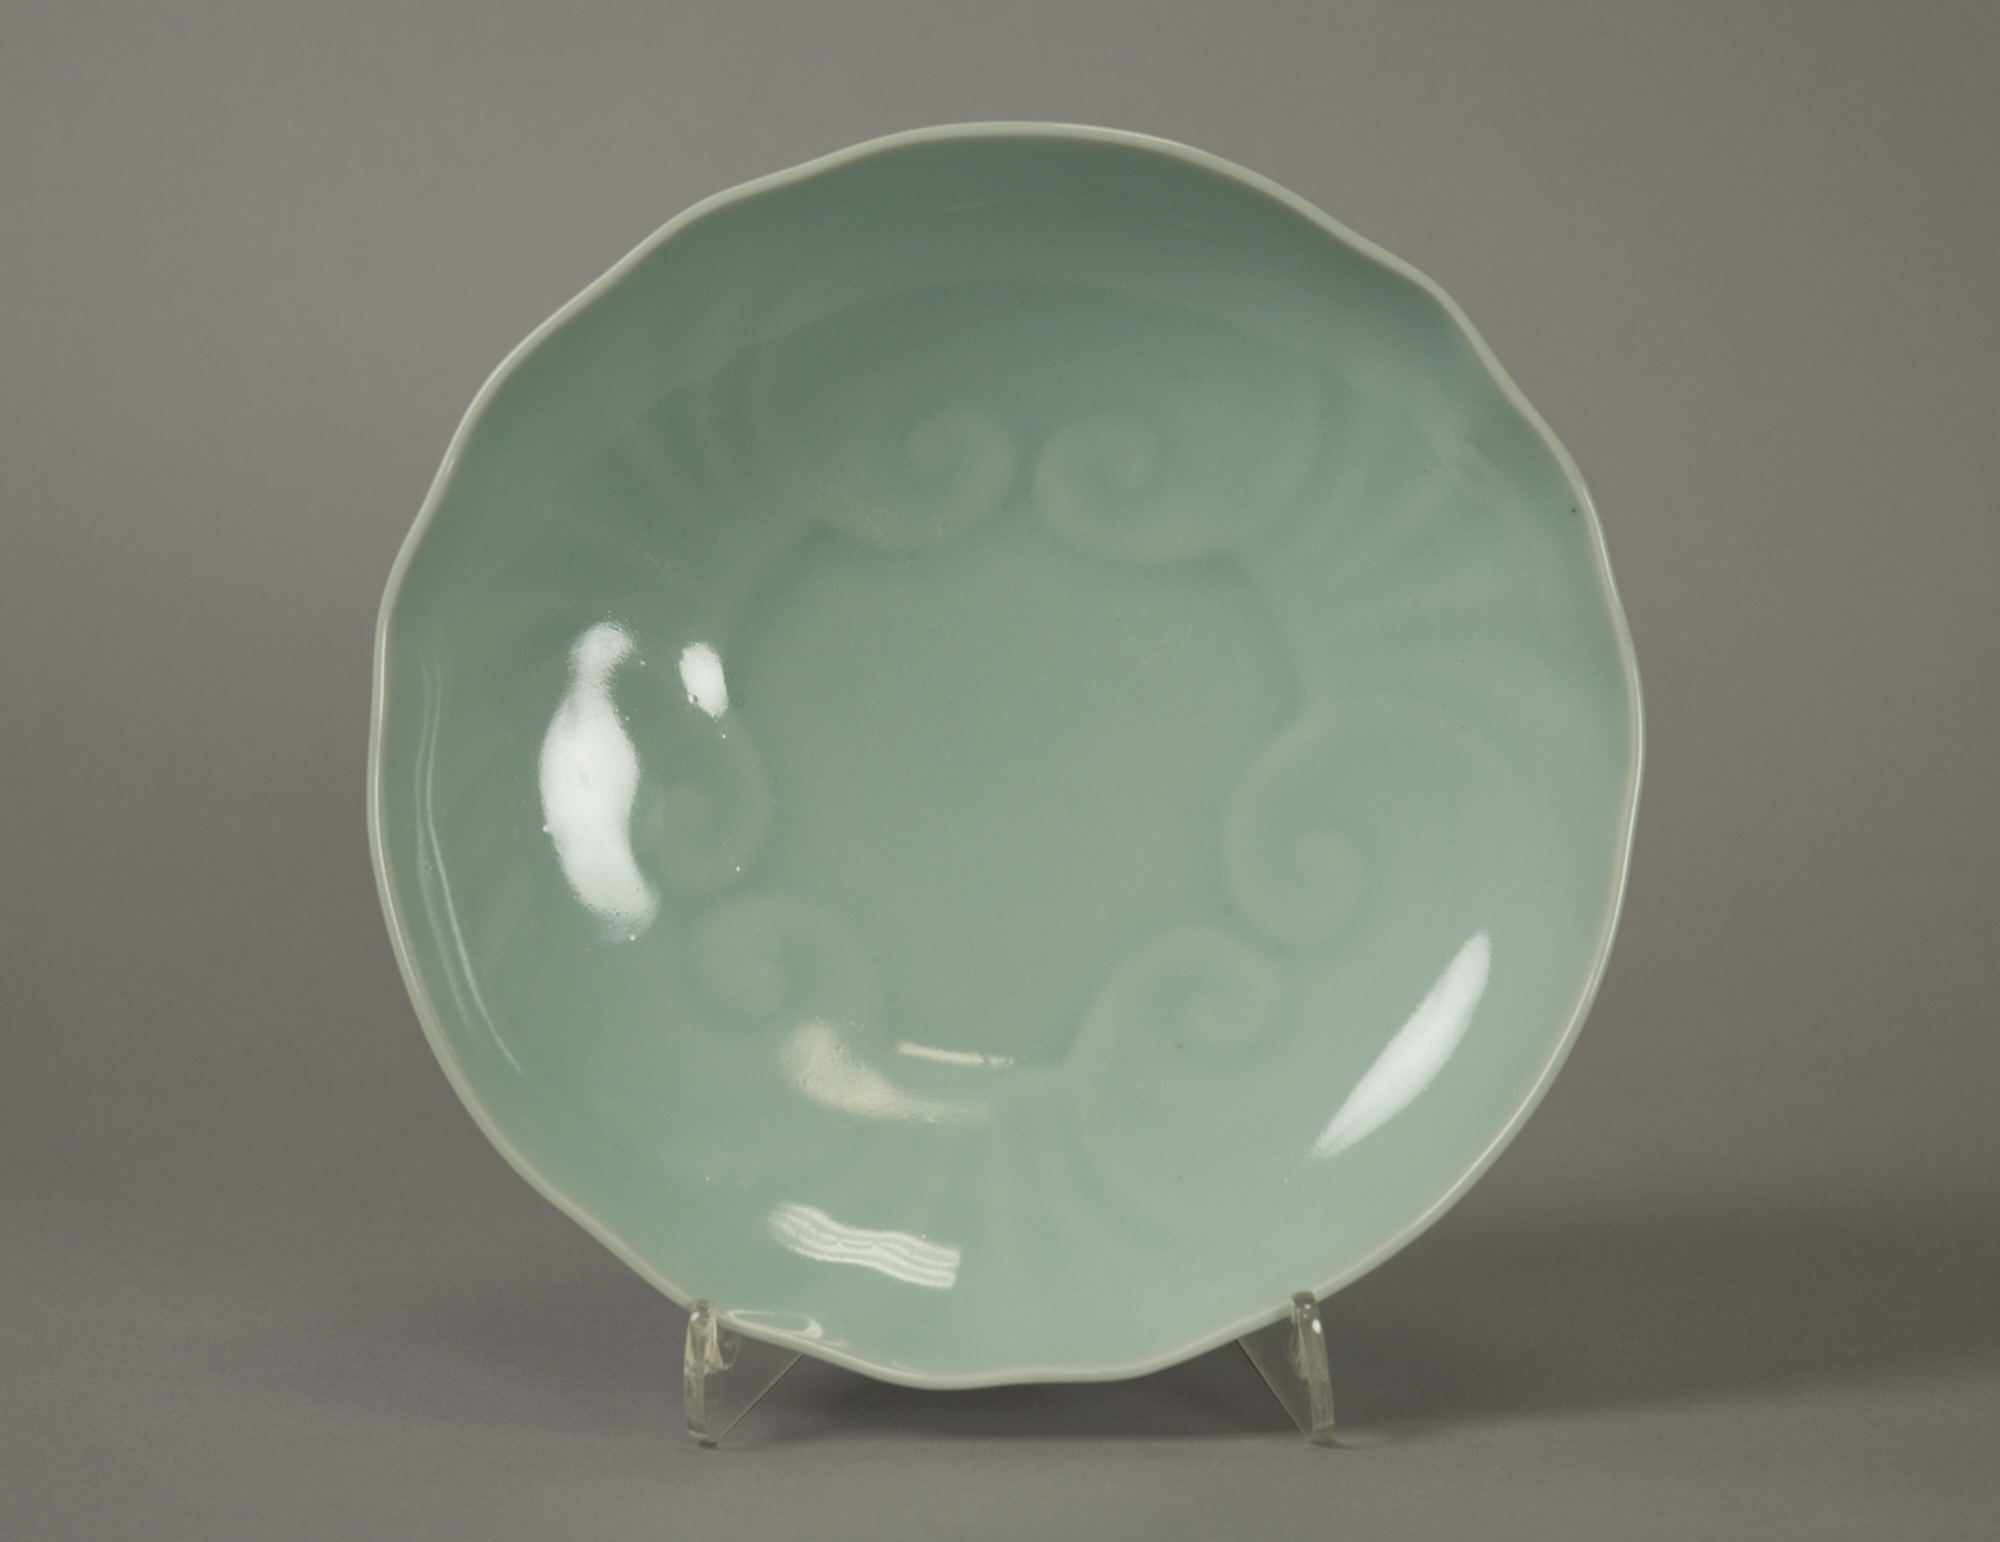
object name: dish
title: Dish Incised with Floral Design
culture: japanese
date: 1780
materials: ceramic glaze, glaze, porcelain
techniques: molding, relief